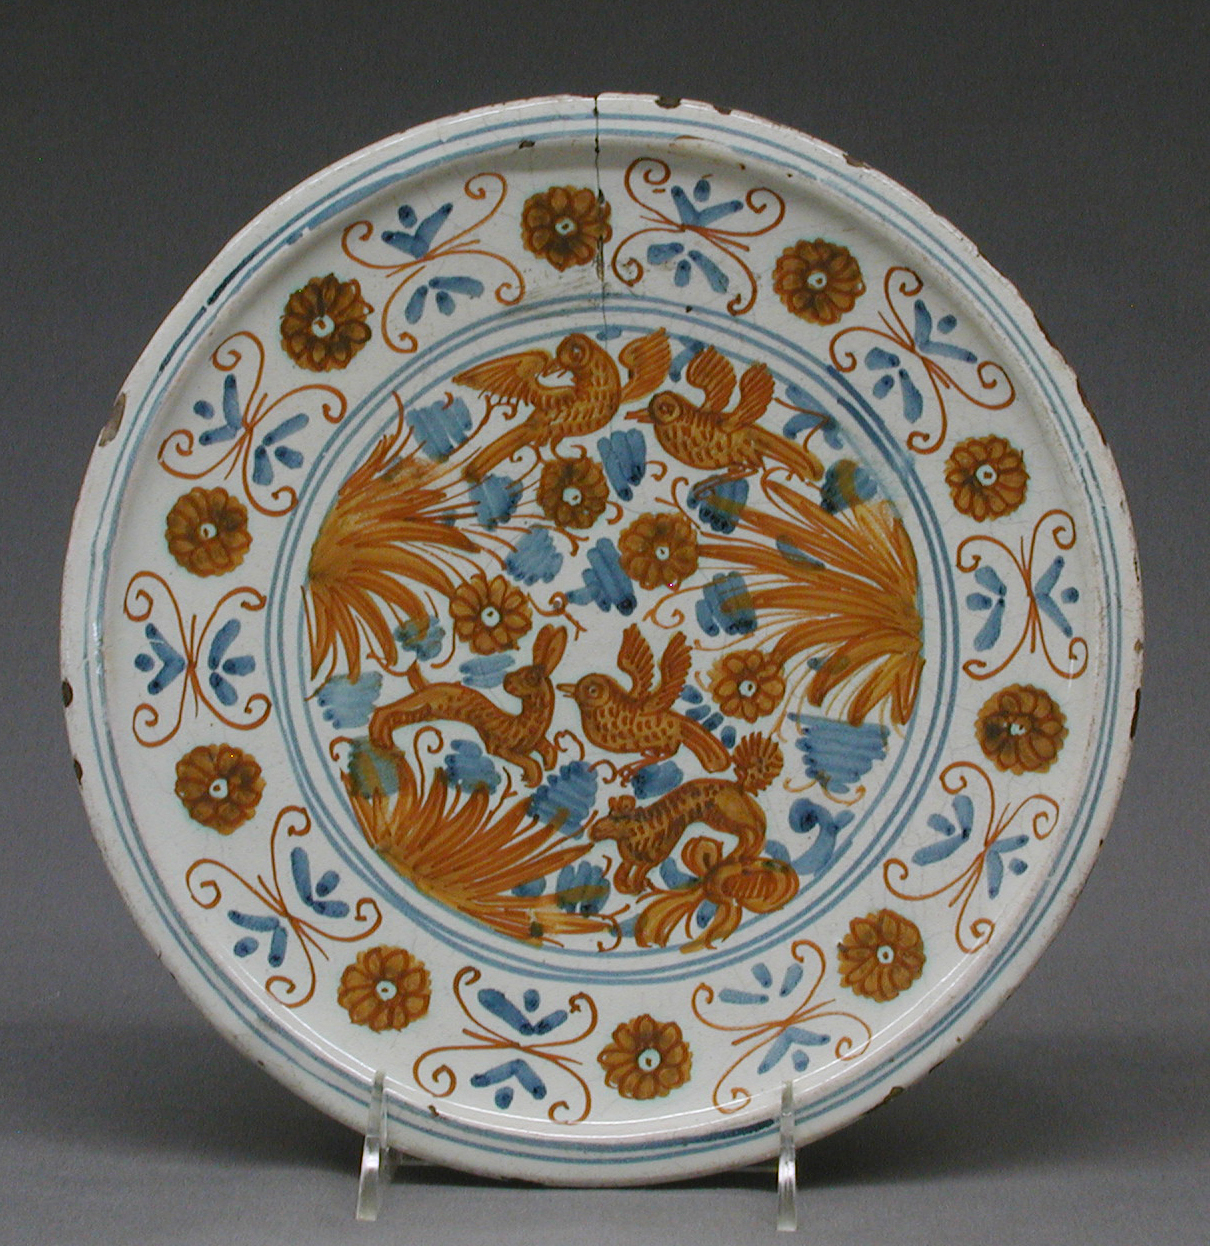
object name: tazza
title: Dish on a low foot (Tazza)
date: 1701-1733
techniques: enamel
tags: animals,birds,flowers